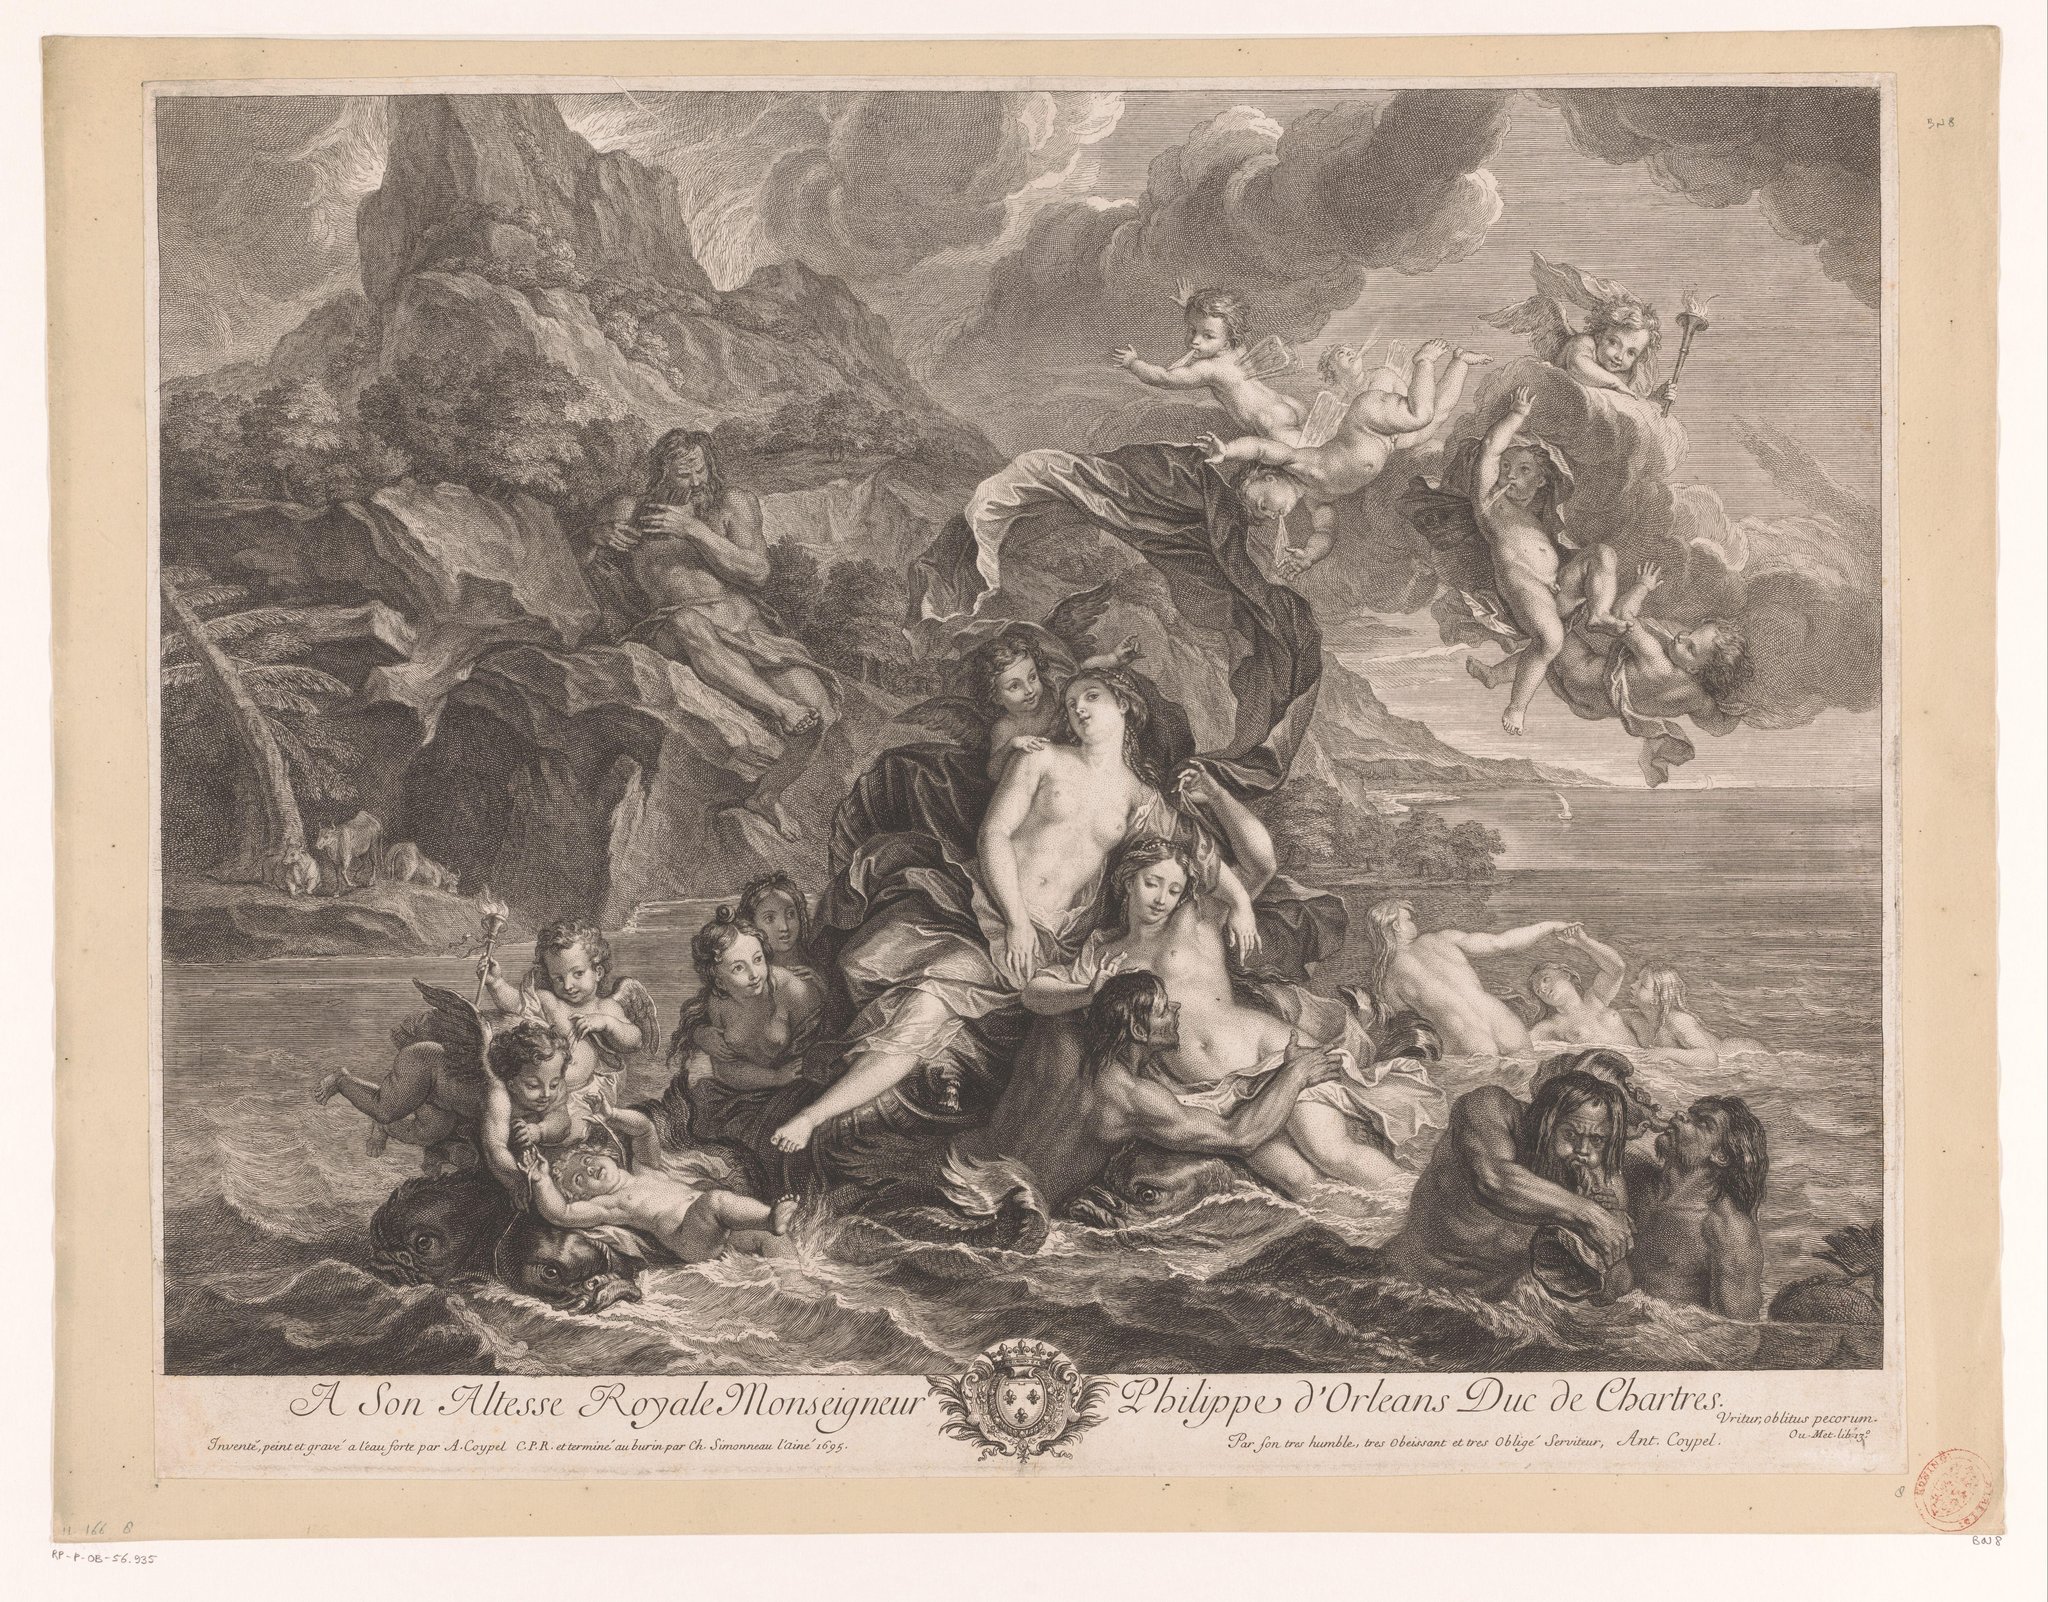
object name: print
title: Triomf van Galatea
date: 1695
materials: paper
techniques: engraving, etching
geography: france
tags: triumph of galatea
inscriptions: collector's mark: Lugt 240